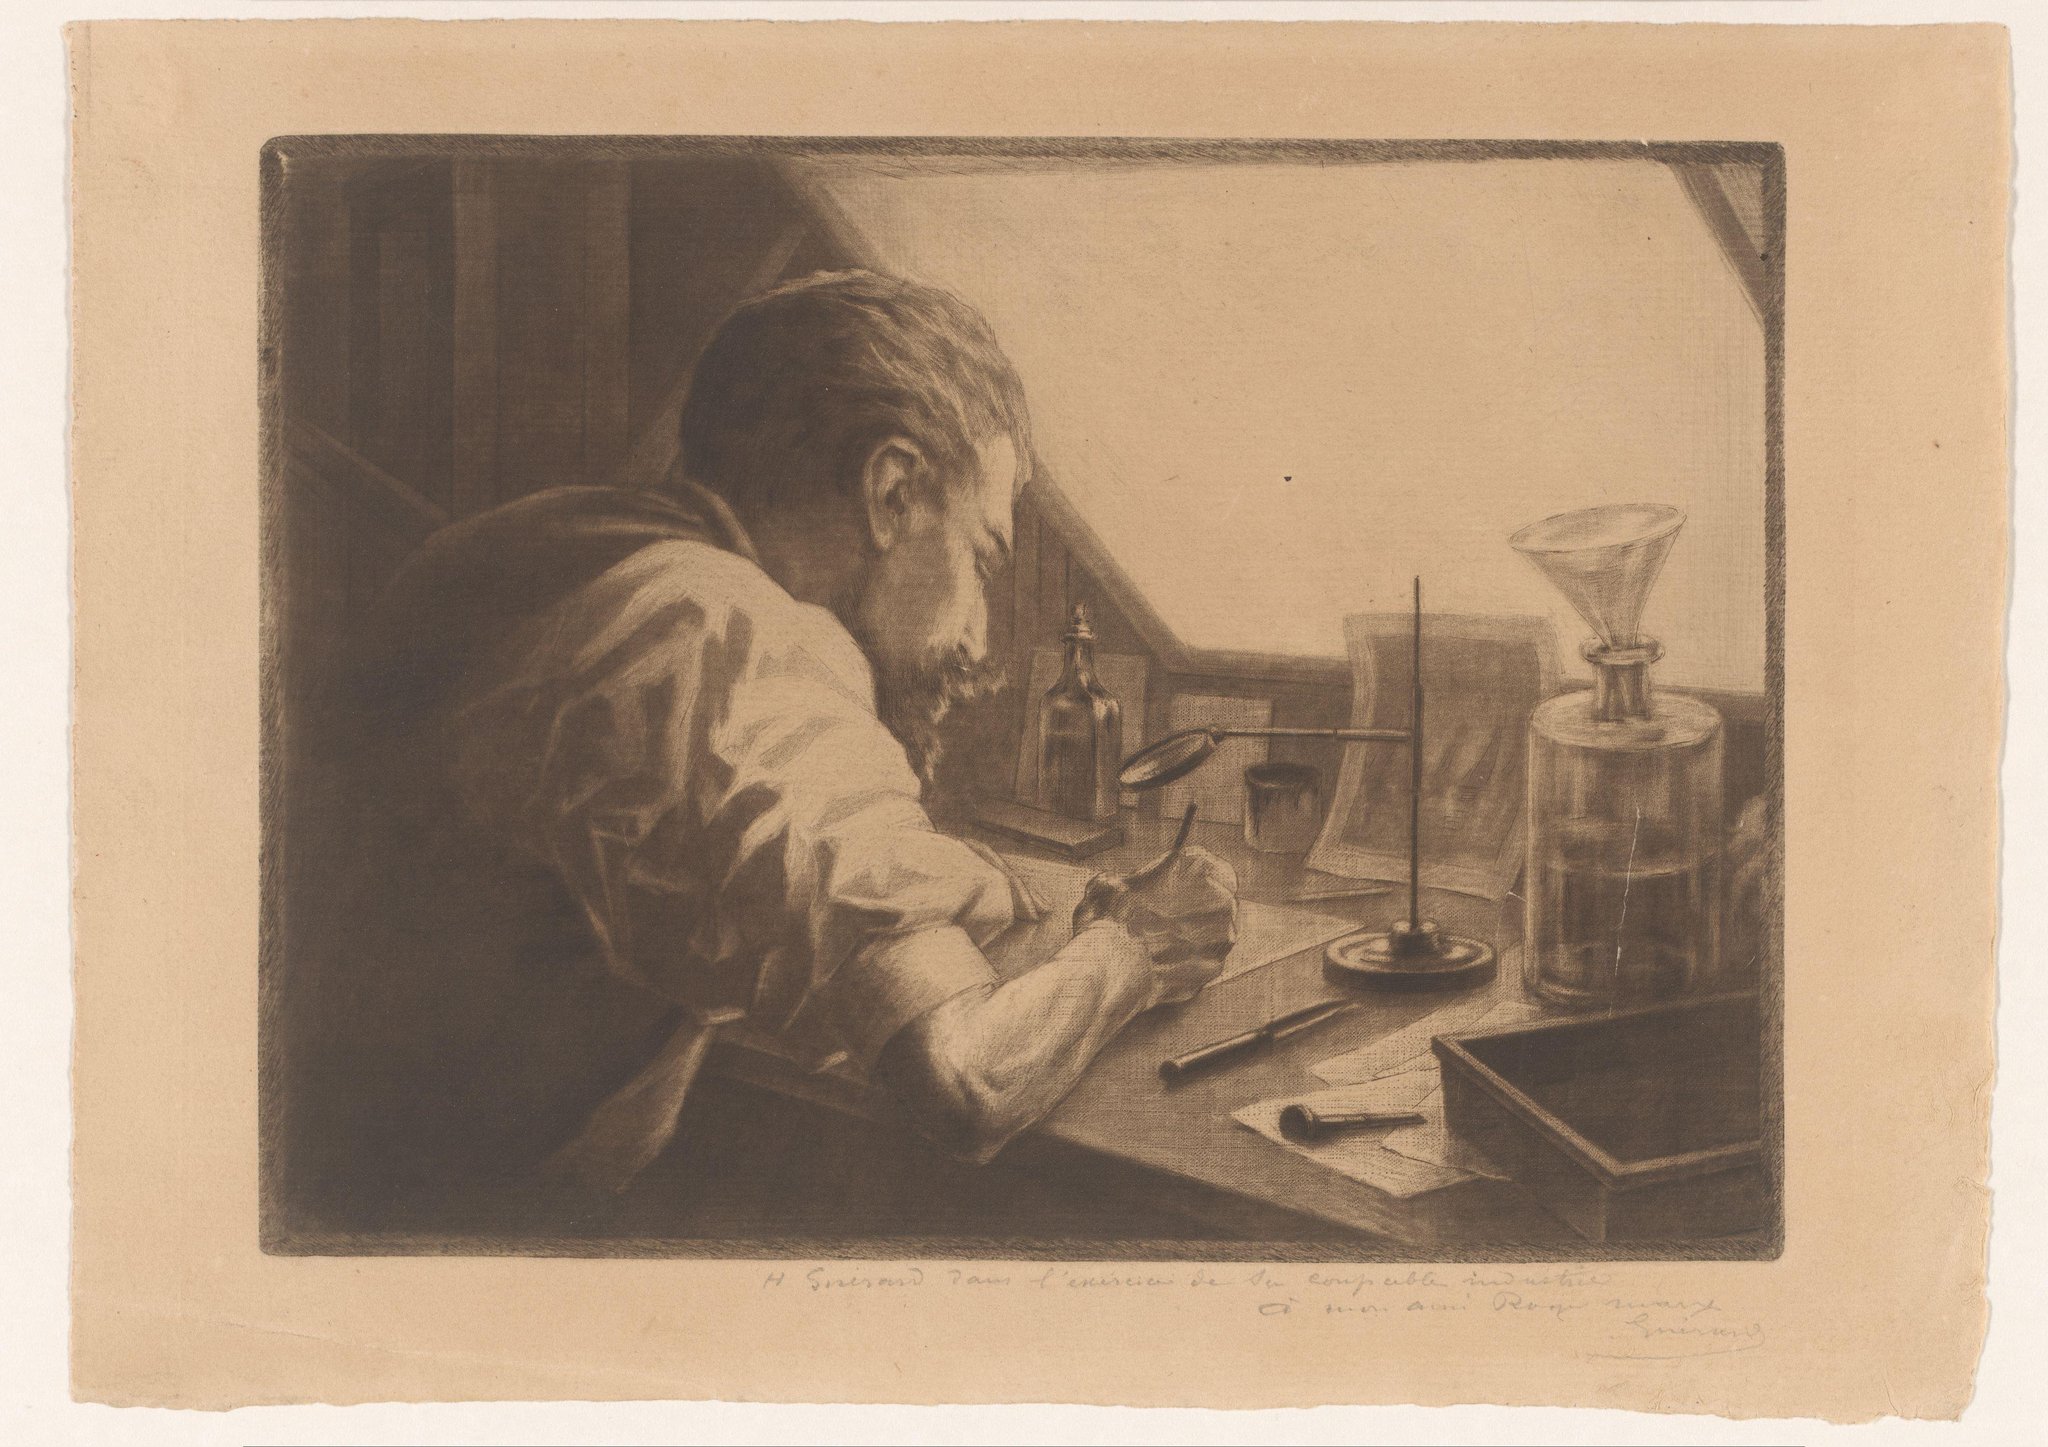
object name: print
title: Portret van Henri Charles Guérard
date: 1864-1894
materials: paper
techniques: retroussage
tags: print maker, henri charles guérard, historical persons, portrait, self-portrait of graphic artist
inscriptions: collector's mark: Lugt 2228